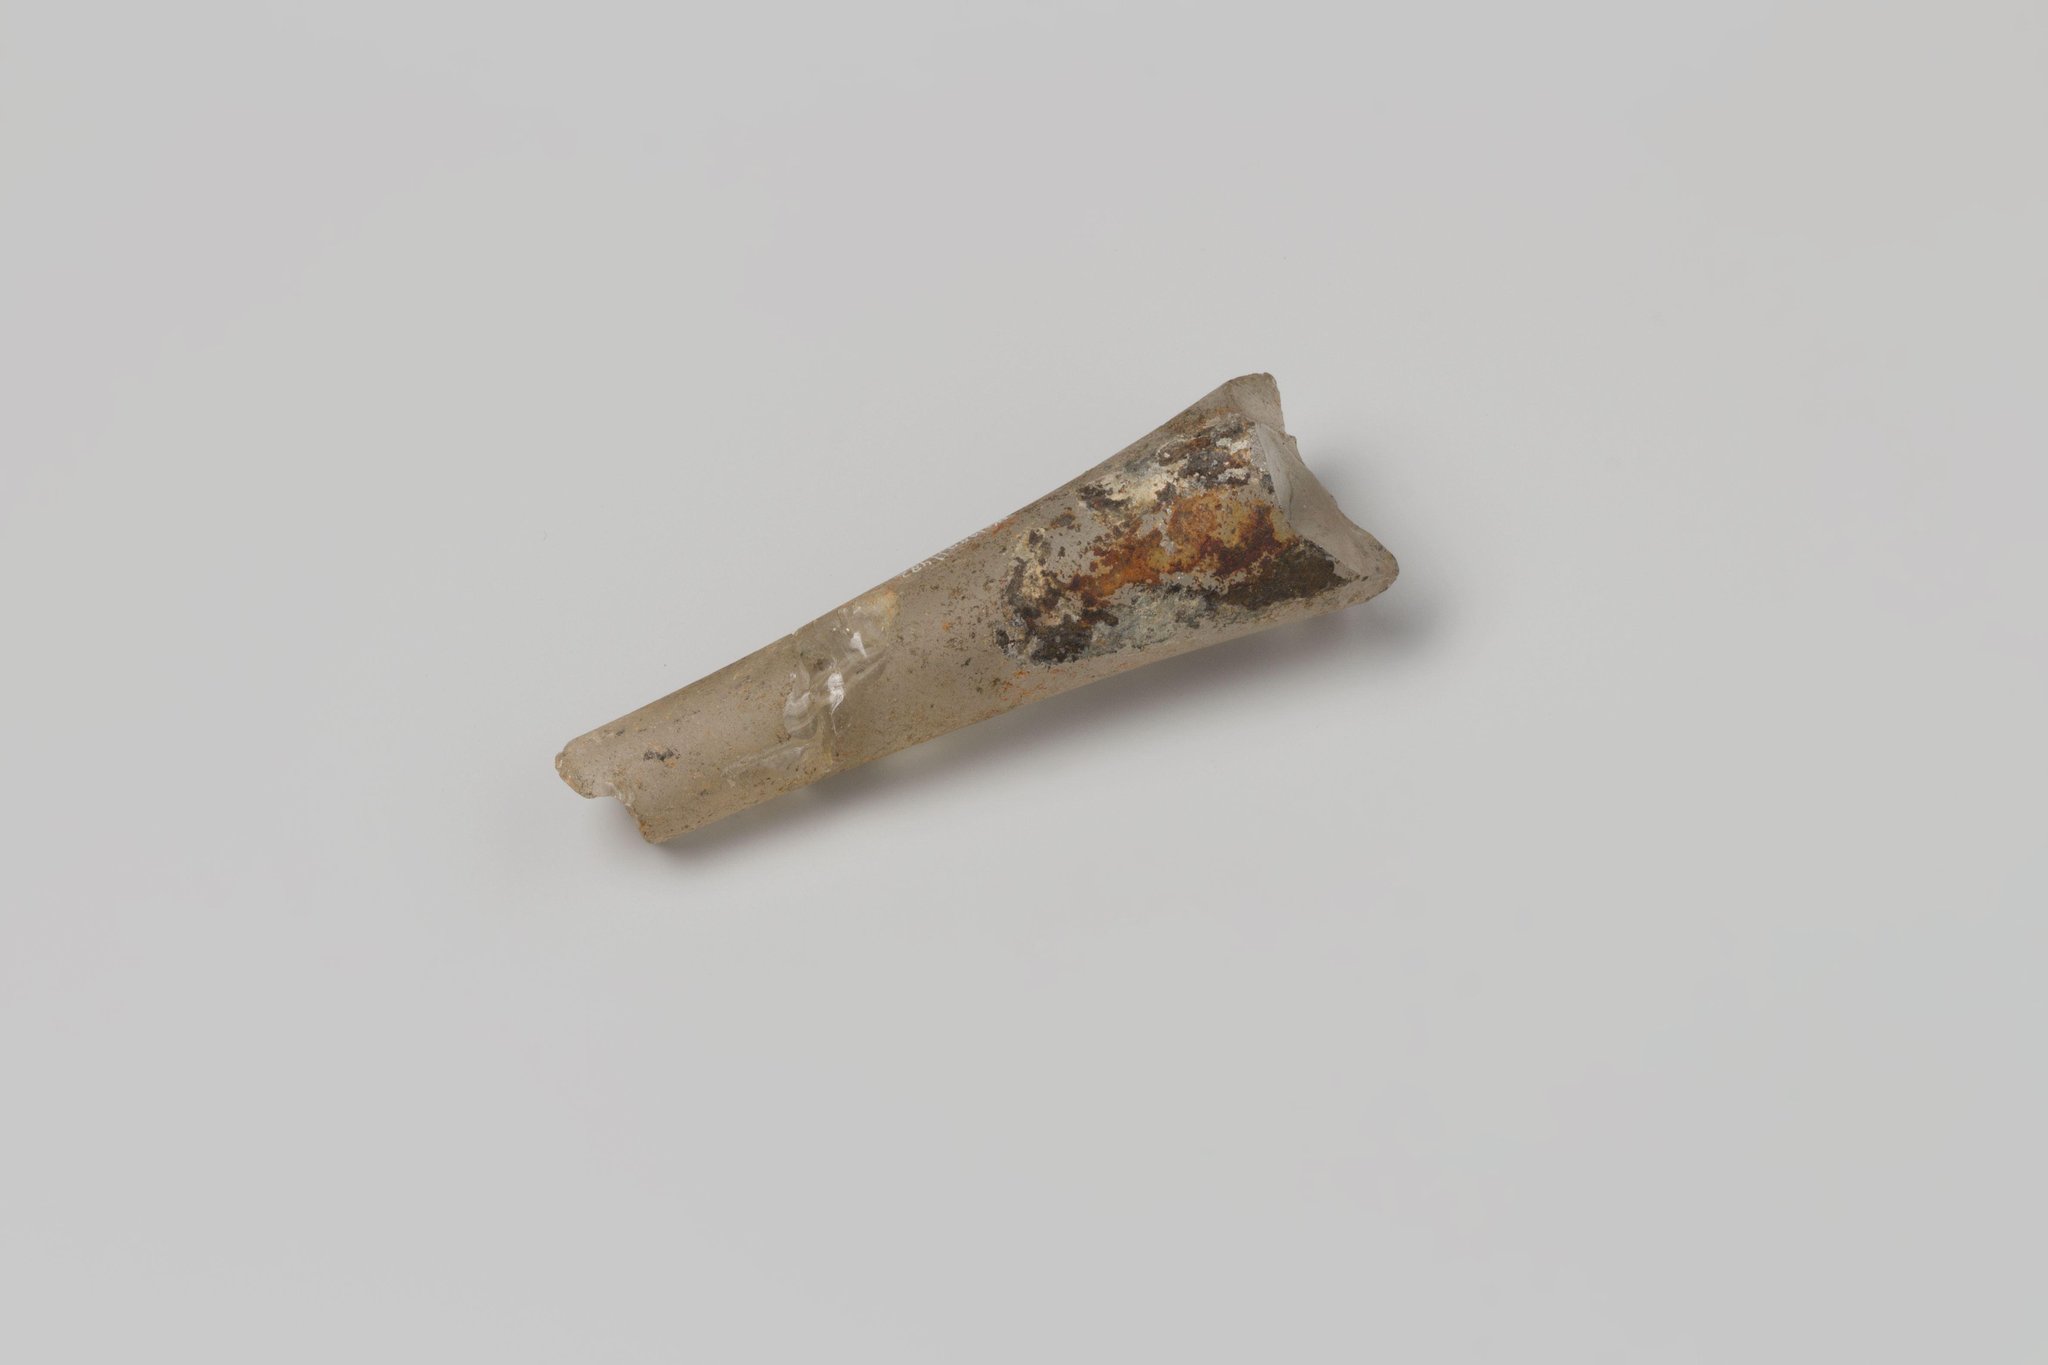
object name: drinking glass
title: Rechte steel van glas uit het wrak van de Oost-Indiëvaarder Hollandia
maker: Anonymous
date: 1700-1743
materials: glass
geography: netherlands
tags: verenigde oostindische compagnie, hollandia (schip), annet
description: Glass, stem glass, stems, plain; fragm, id. NG 1980-27H798.